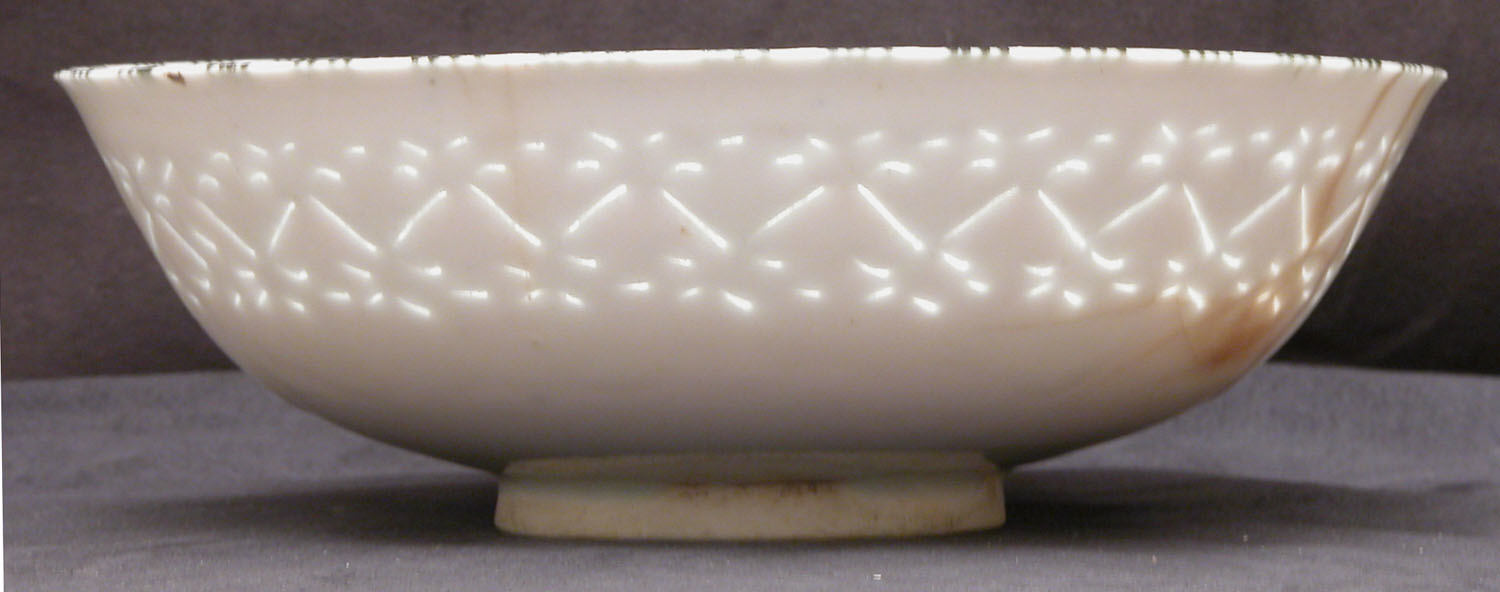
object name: bowl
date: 1601-1800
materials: stonepaste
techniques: painting, underglaze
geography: iran